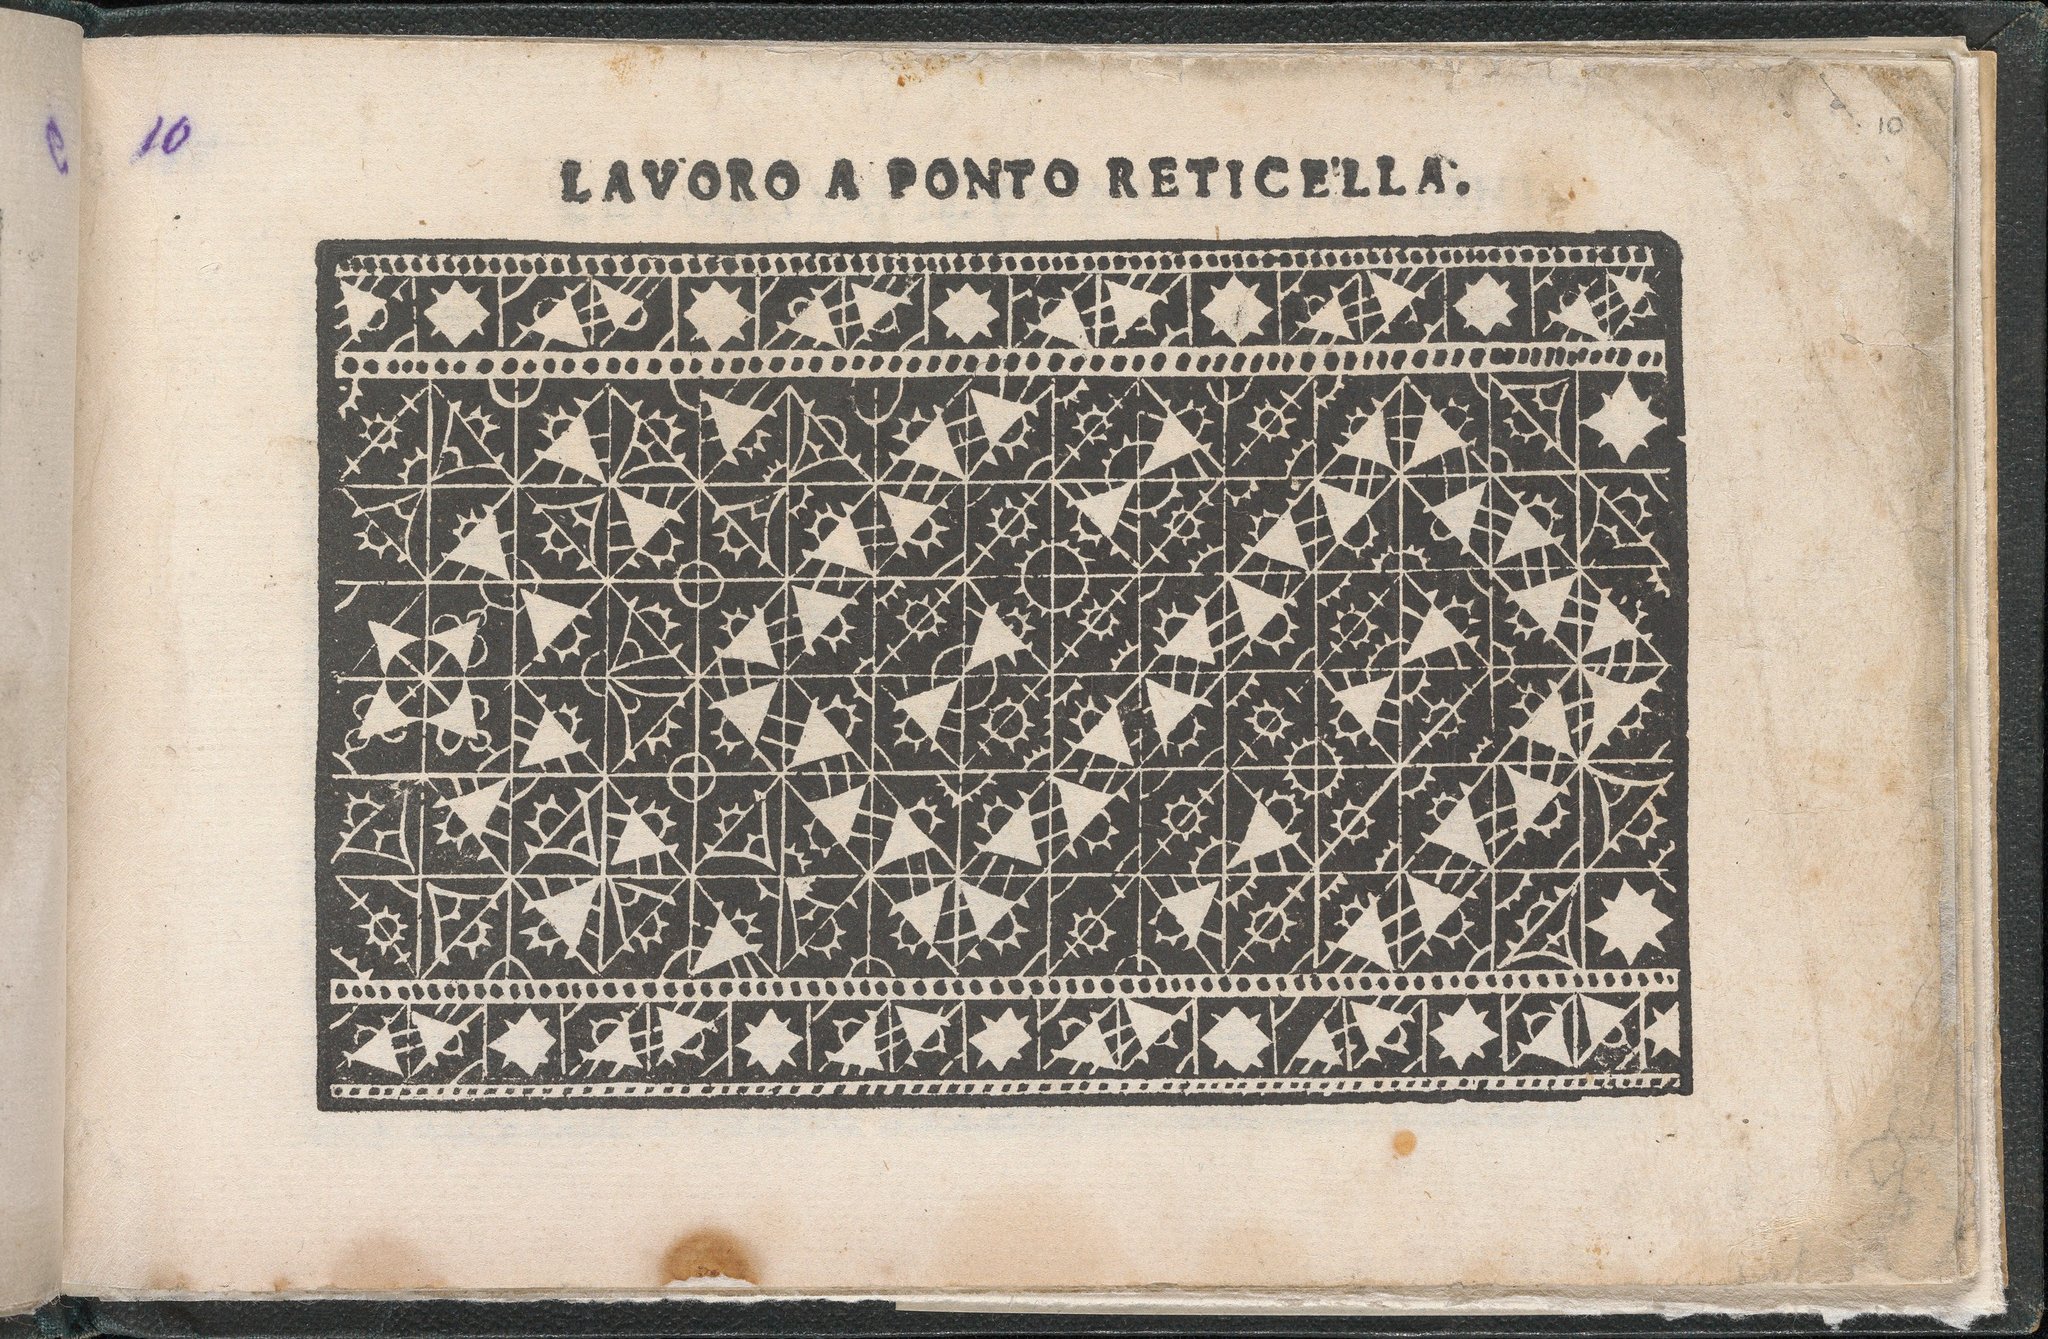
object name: book print ornament architecture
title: Gemma pretiosa della virtuose donne, page 10 (recto)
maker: isabella catanea parasole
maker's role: designer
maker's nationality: italian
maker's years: 1565-1625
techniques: woodcut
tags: ornament